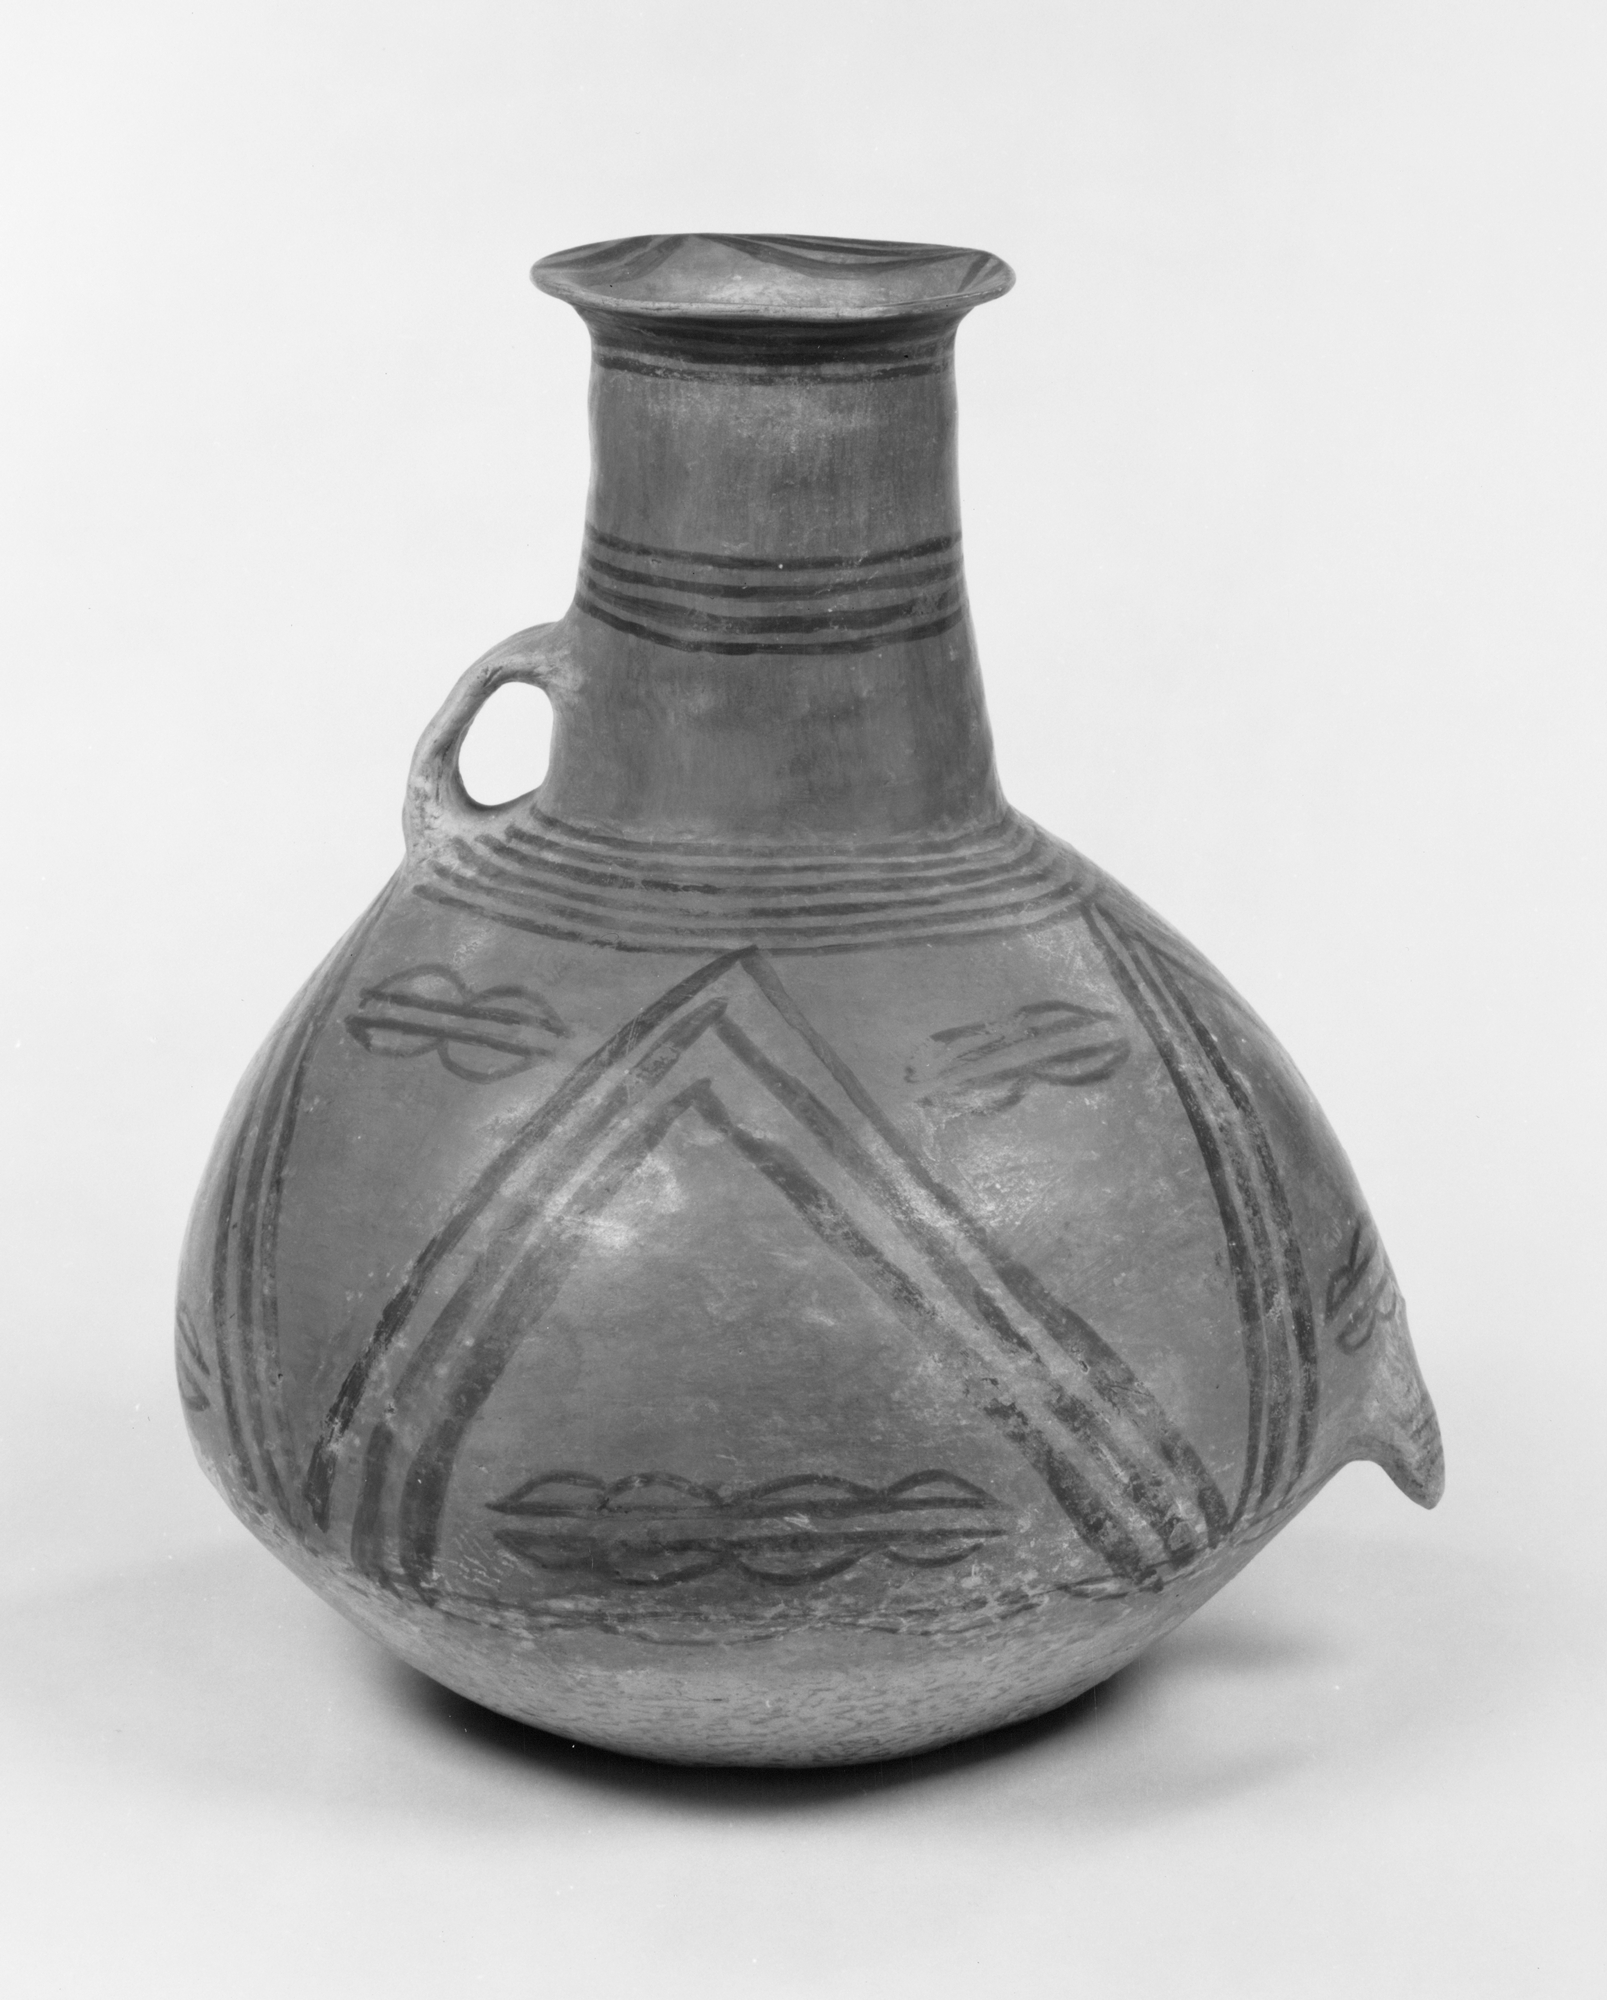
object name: pitcher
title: Pitcher (Hu)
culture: chinese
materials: earthenware, pigment